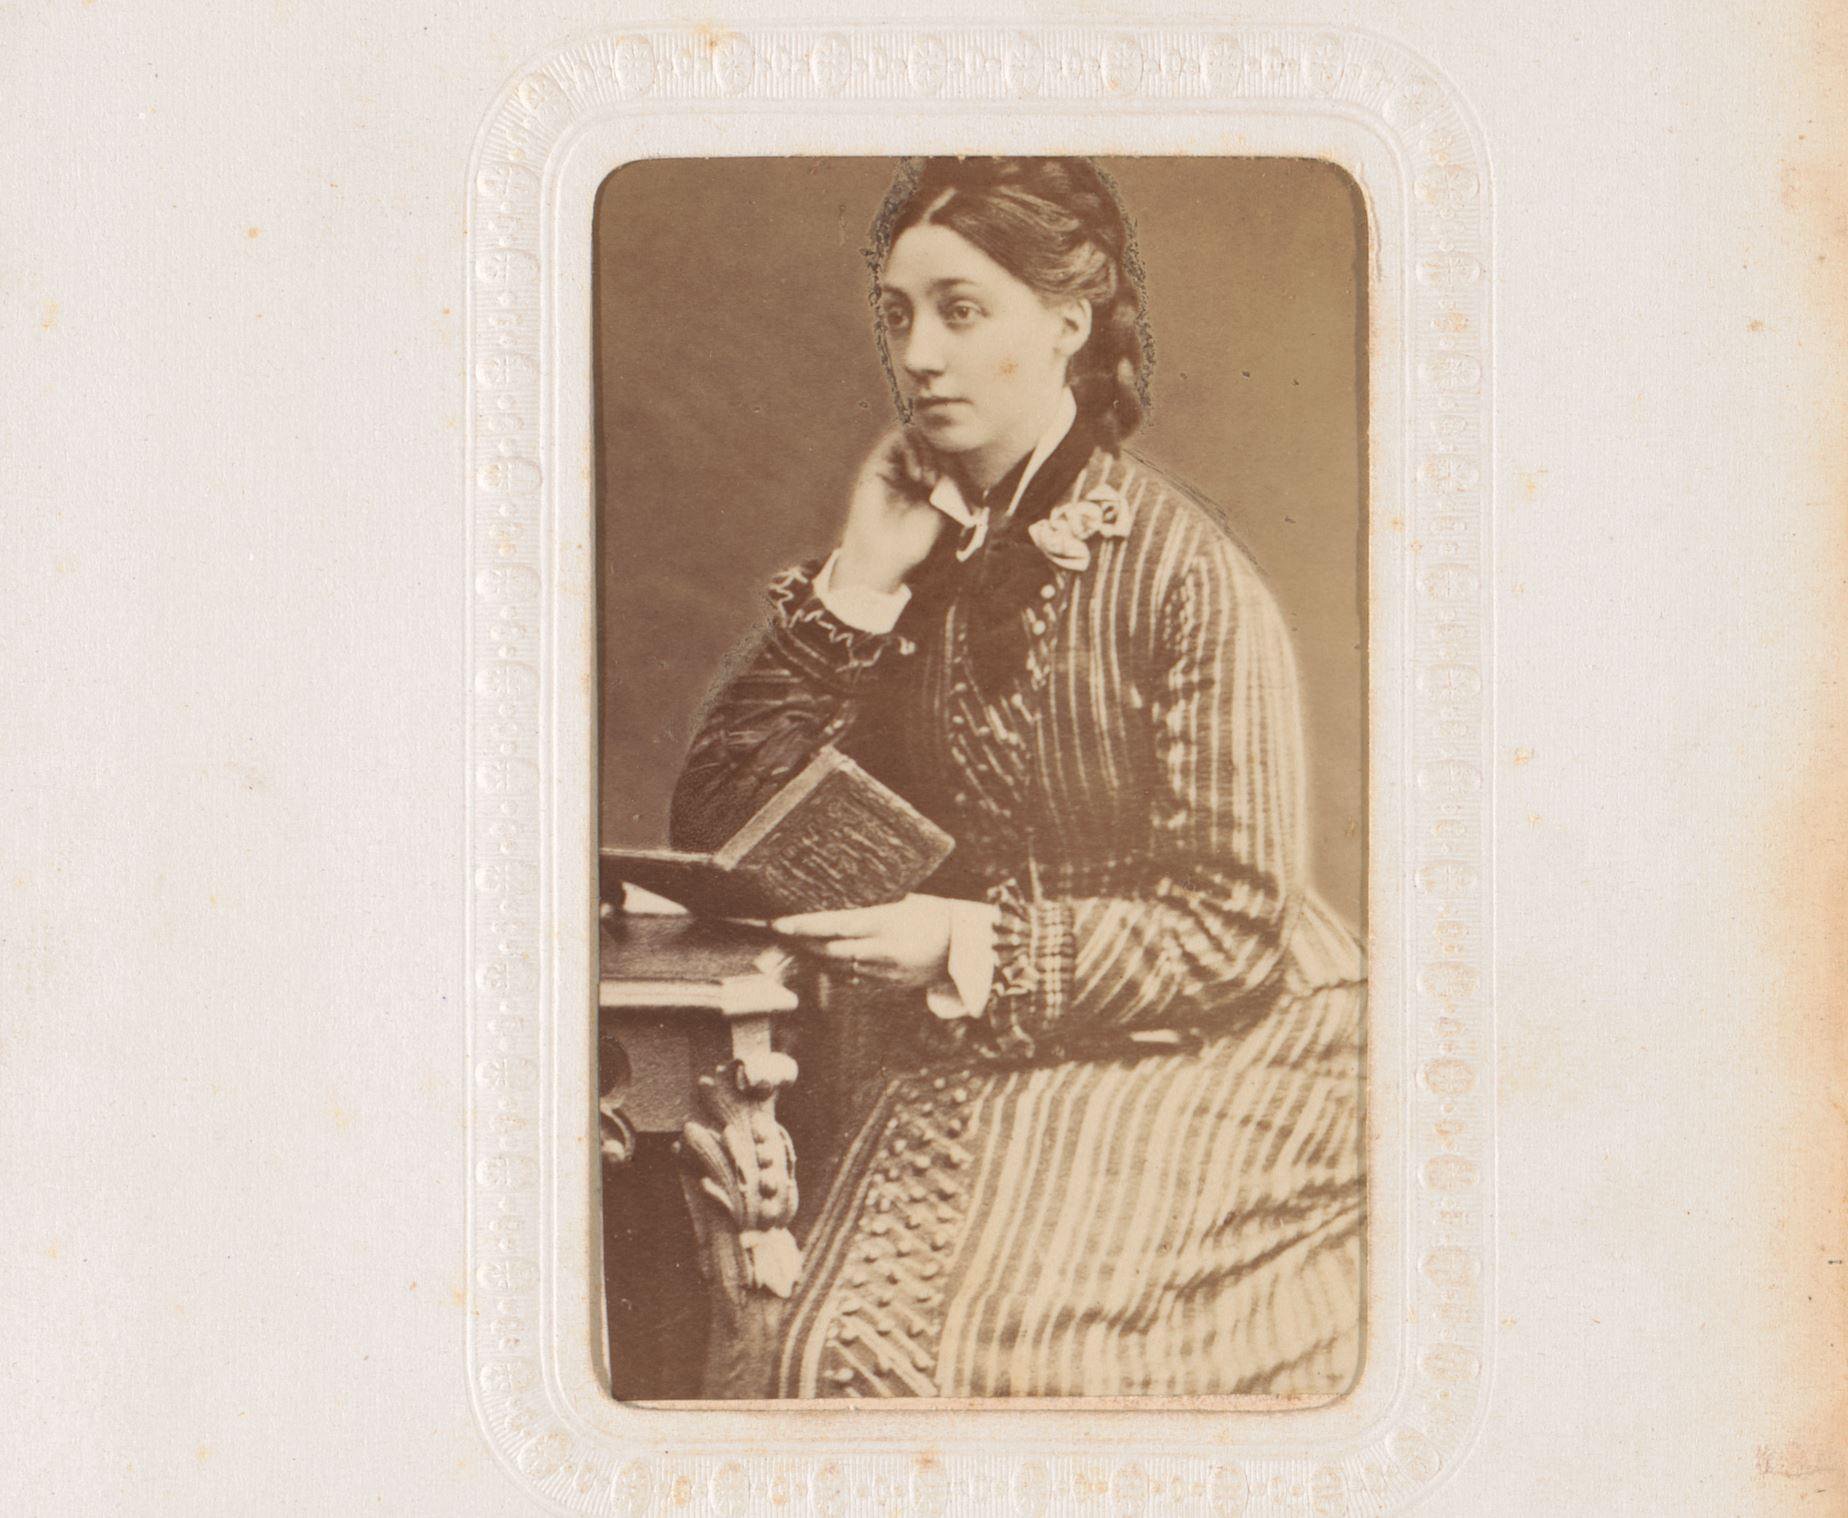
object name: album leaf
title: Portret van een vrouw met open boek in de hand, zittend aan een tafel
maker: Anonymous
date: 1860-1900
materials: cardboard, photographic support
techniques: albumen print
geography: netherlands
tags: sitting figure - aa - female human figure, historical persons - bb - woman, book - mm - book open, table